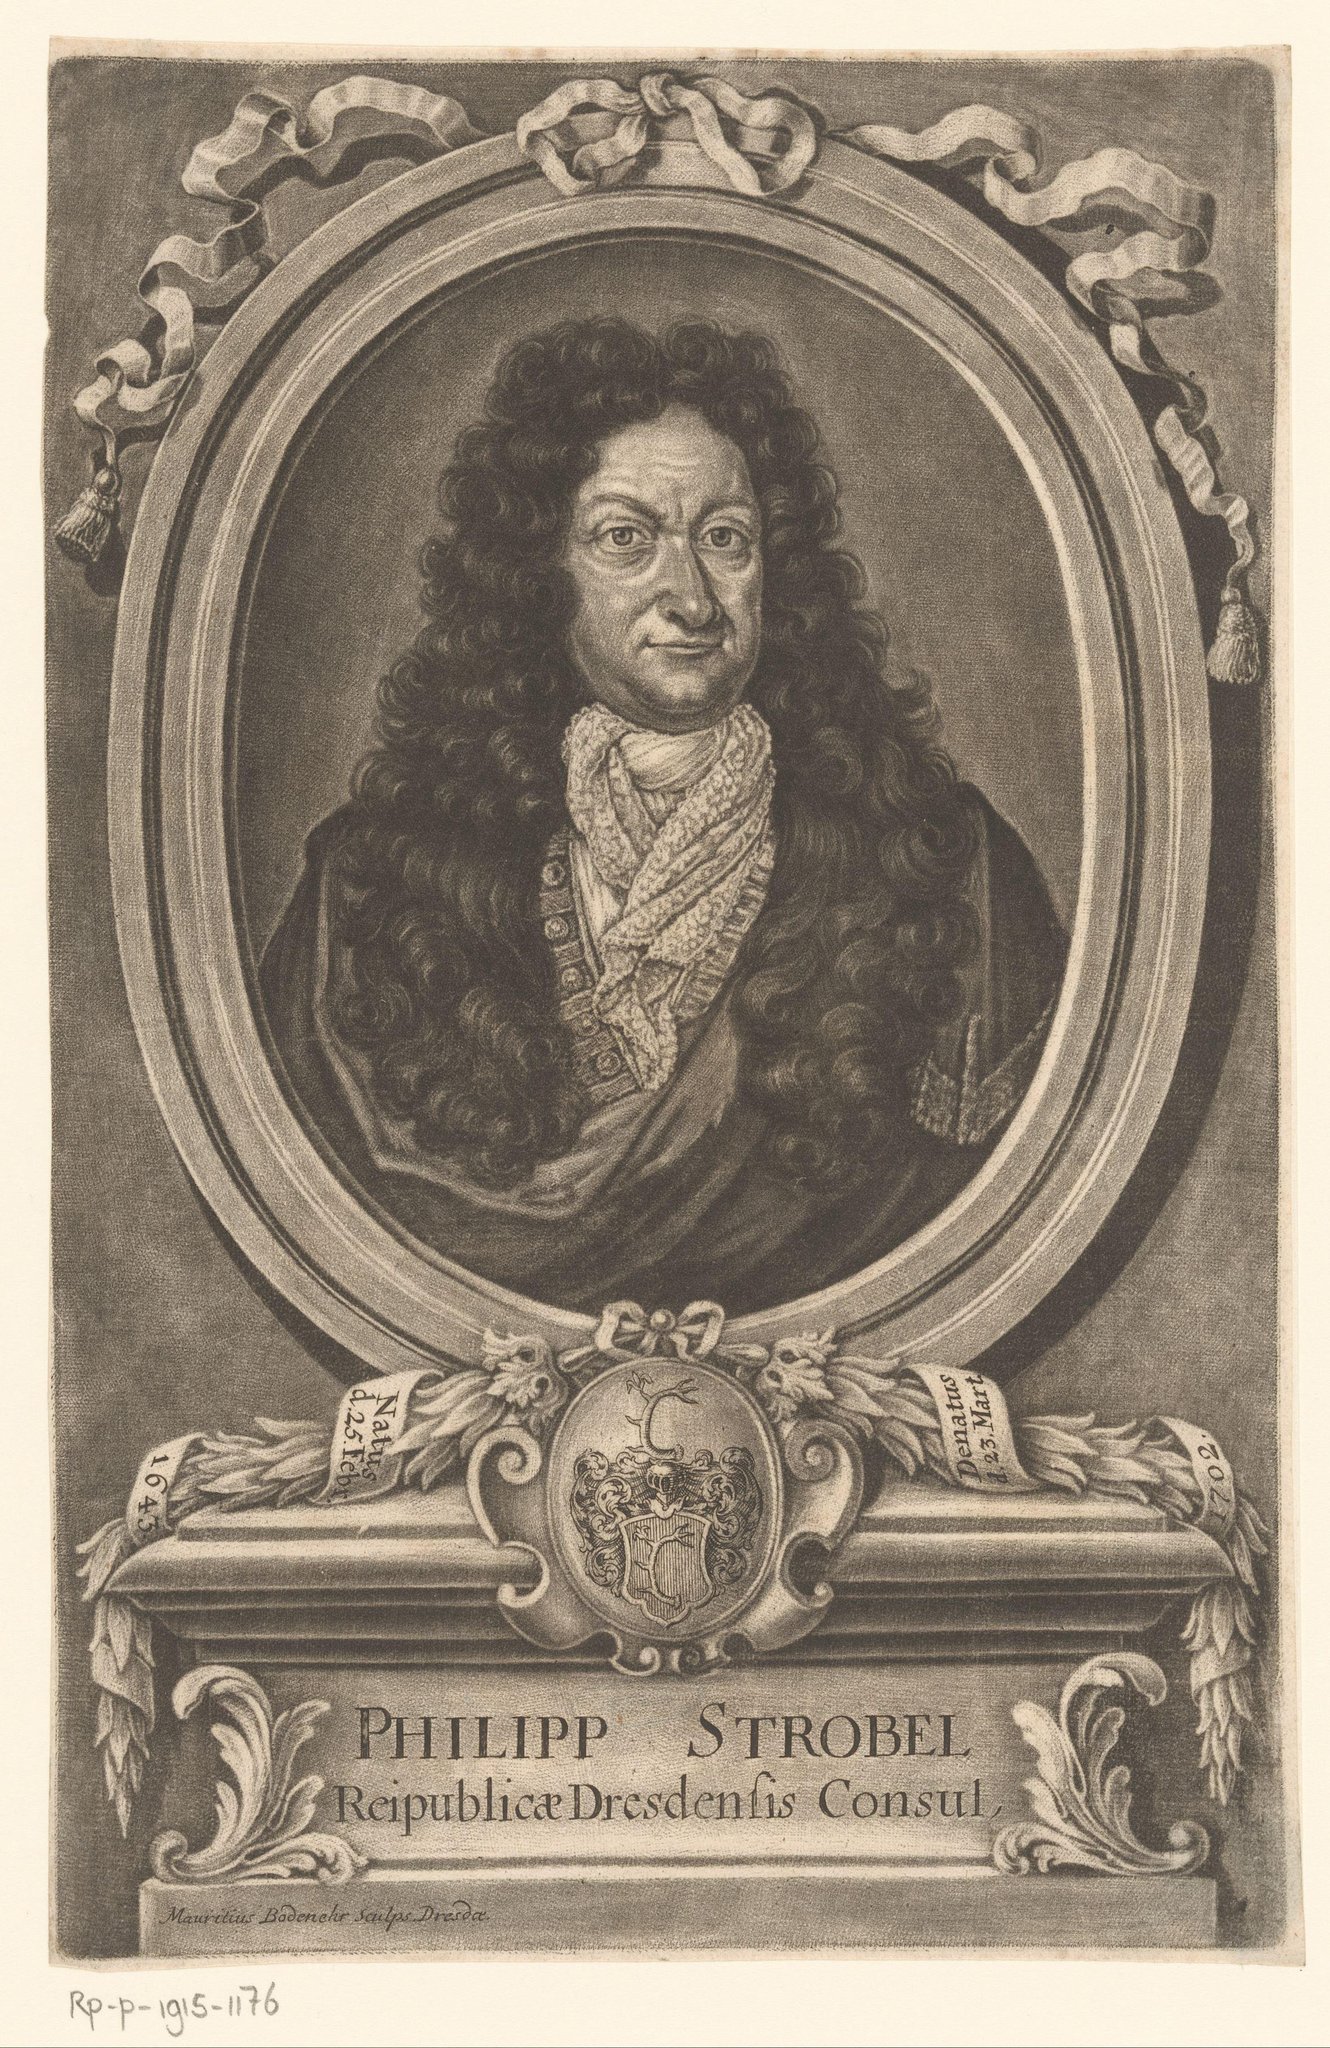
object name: print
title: Portret van Philipp Strobel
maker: moritz bodenehr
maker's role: print maker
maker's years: 1665-1749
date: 1702-1748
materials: paper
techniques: mezzotint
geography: dresden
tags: historical persons, ornament ~ festoon, garland, armorial bearing, heraldry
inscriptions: collector's mark: Lugt 2228